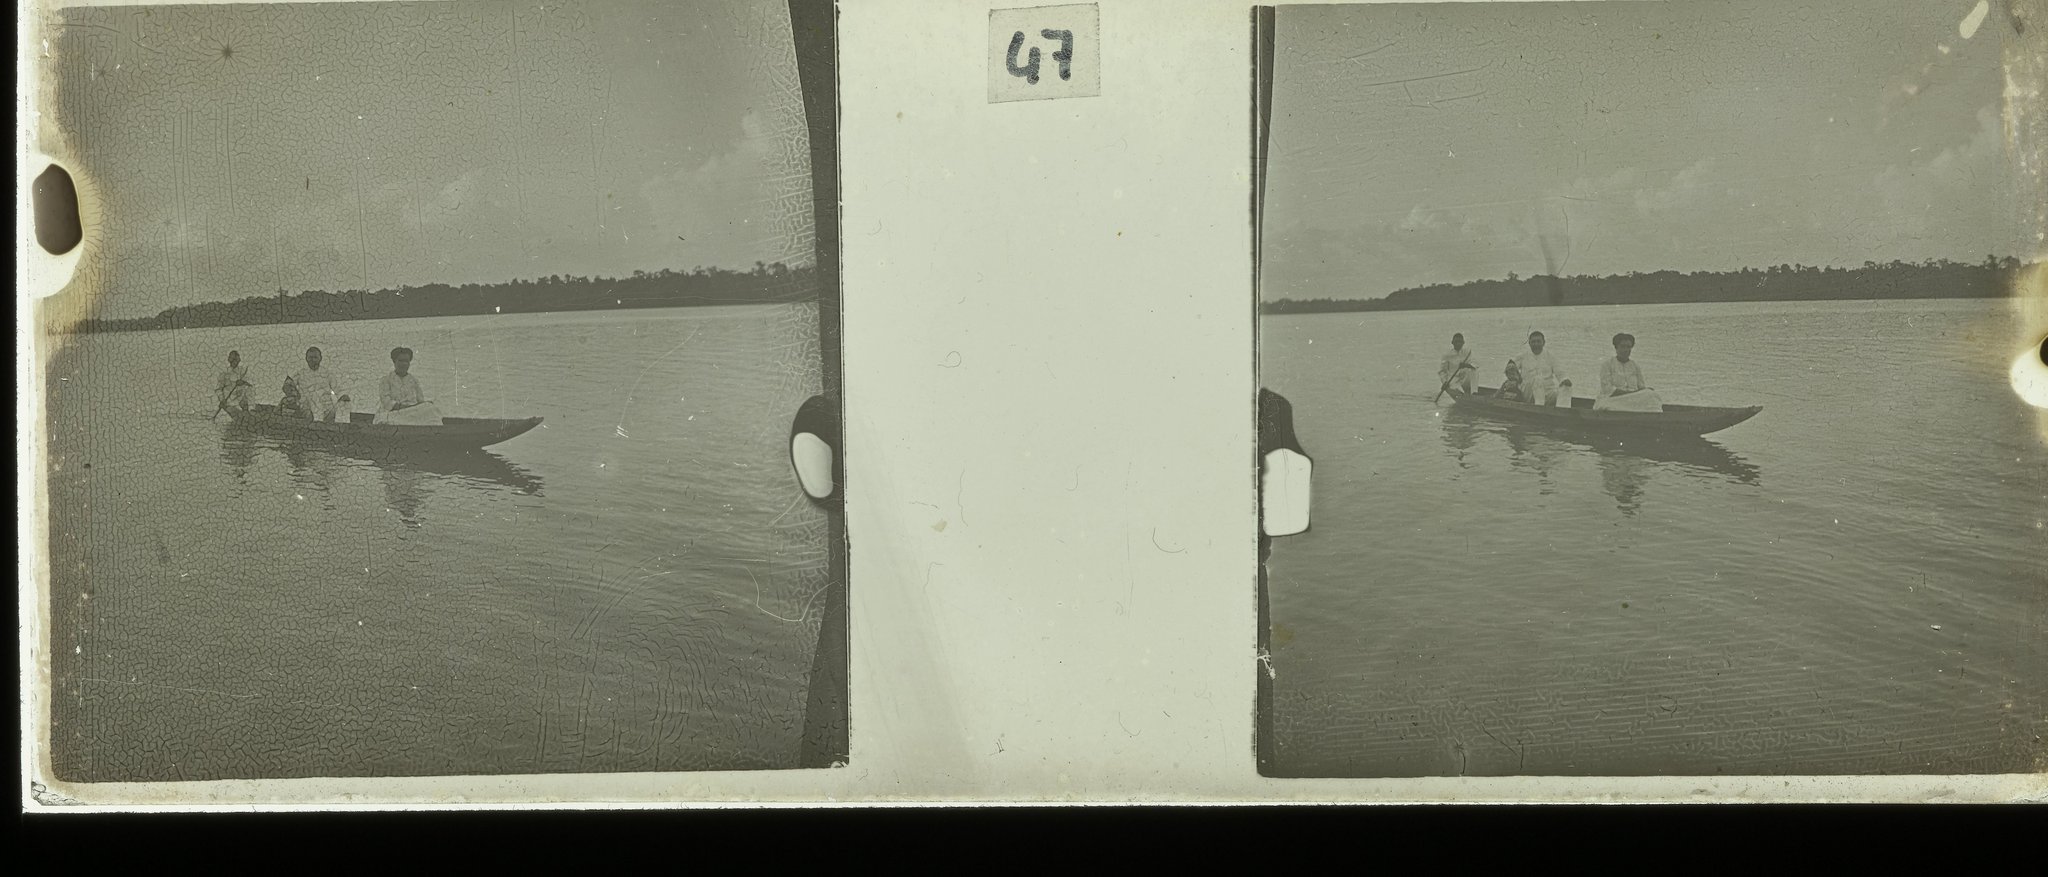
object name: stereograph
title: Theodoor en Lize Brouwers met hun zoon Gerard in een korjaal op de Surinamerivier.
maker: Anonymous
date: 1913-1915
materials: glass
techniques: photography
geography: suriname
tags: haarlem, amsterdam, theodoor brouwers, suriname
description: In de periode 1911-1932 woonde op plantage Accaribo in Suriname de familie Brouwers van wie de foto's afkomstig zijn. Rond 1910 vond Theodoor Brouwers werk op plantage Accaribo. In 1929 werd hij eigenaar van de plantage. Op Accaribo werden in zijn tijd bananen geproduceerd en wat koffie.